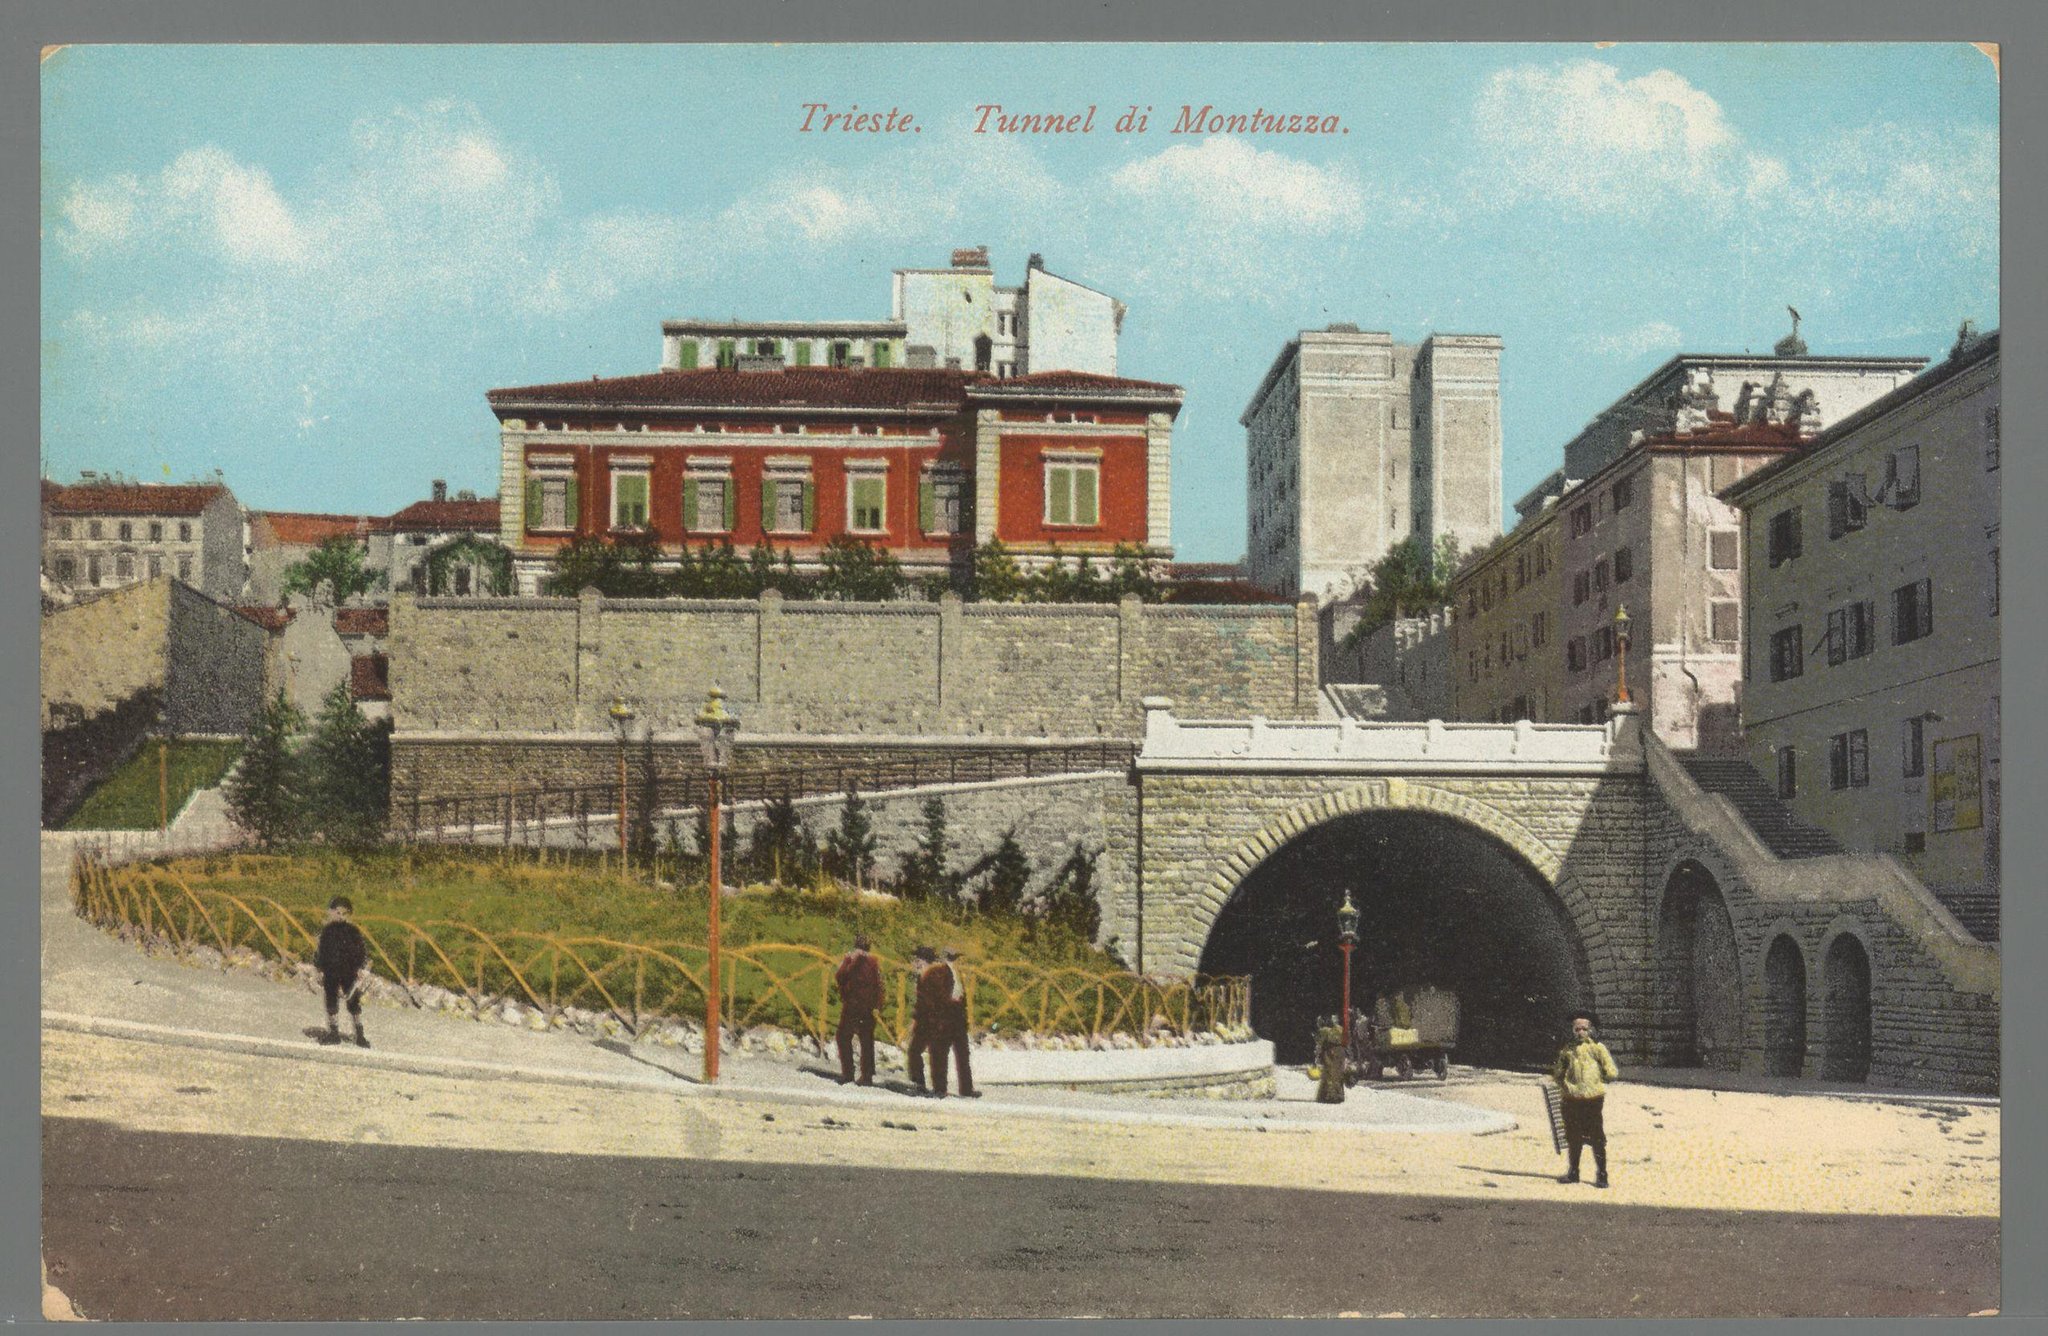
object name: ansichtkaart, prentbriefkaart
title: Trieste. Tunnel di Montuza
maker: Anonymous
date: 1906-1909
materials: cardboard, photographic process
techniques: writing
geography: munich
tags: underground road, tunnel, city-view, and landscape with man-made constructions (+ city(-scape) with figures, staffage)